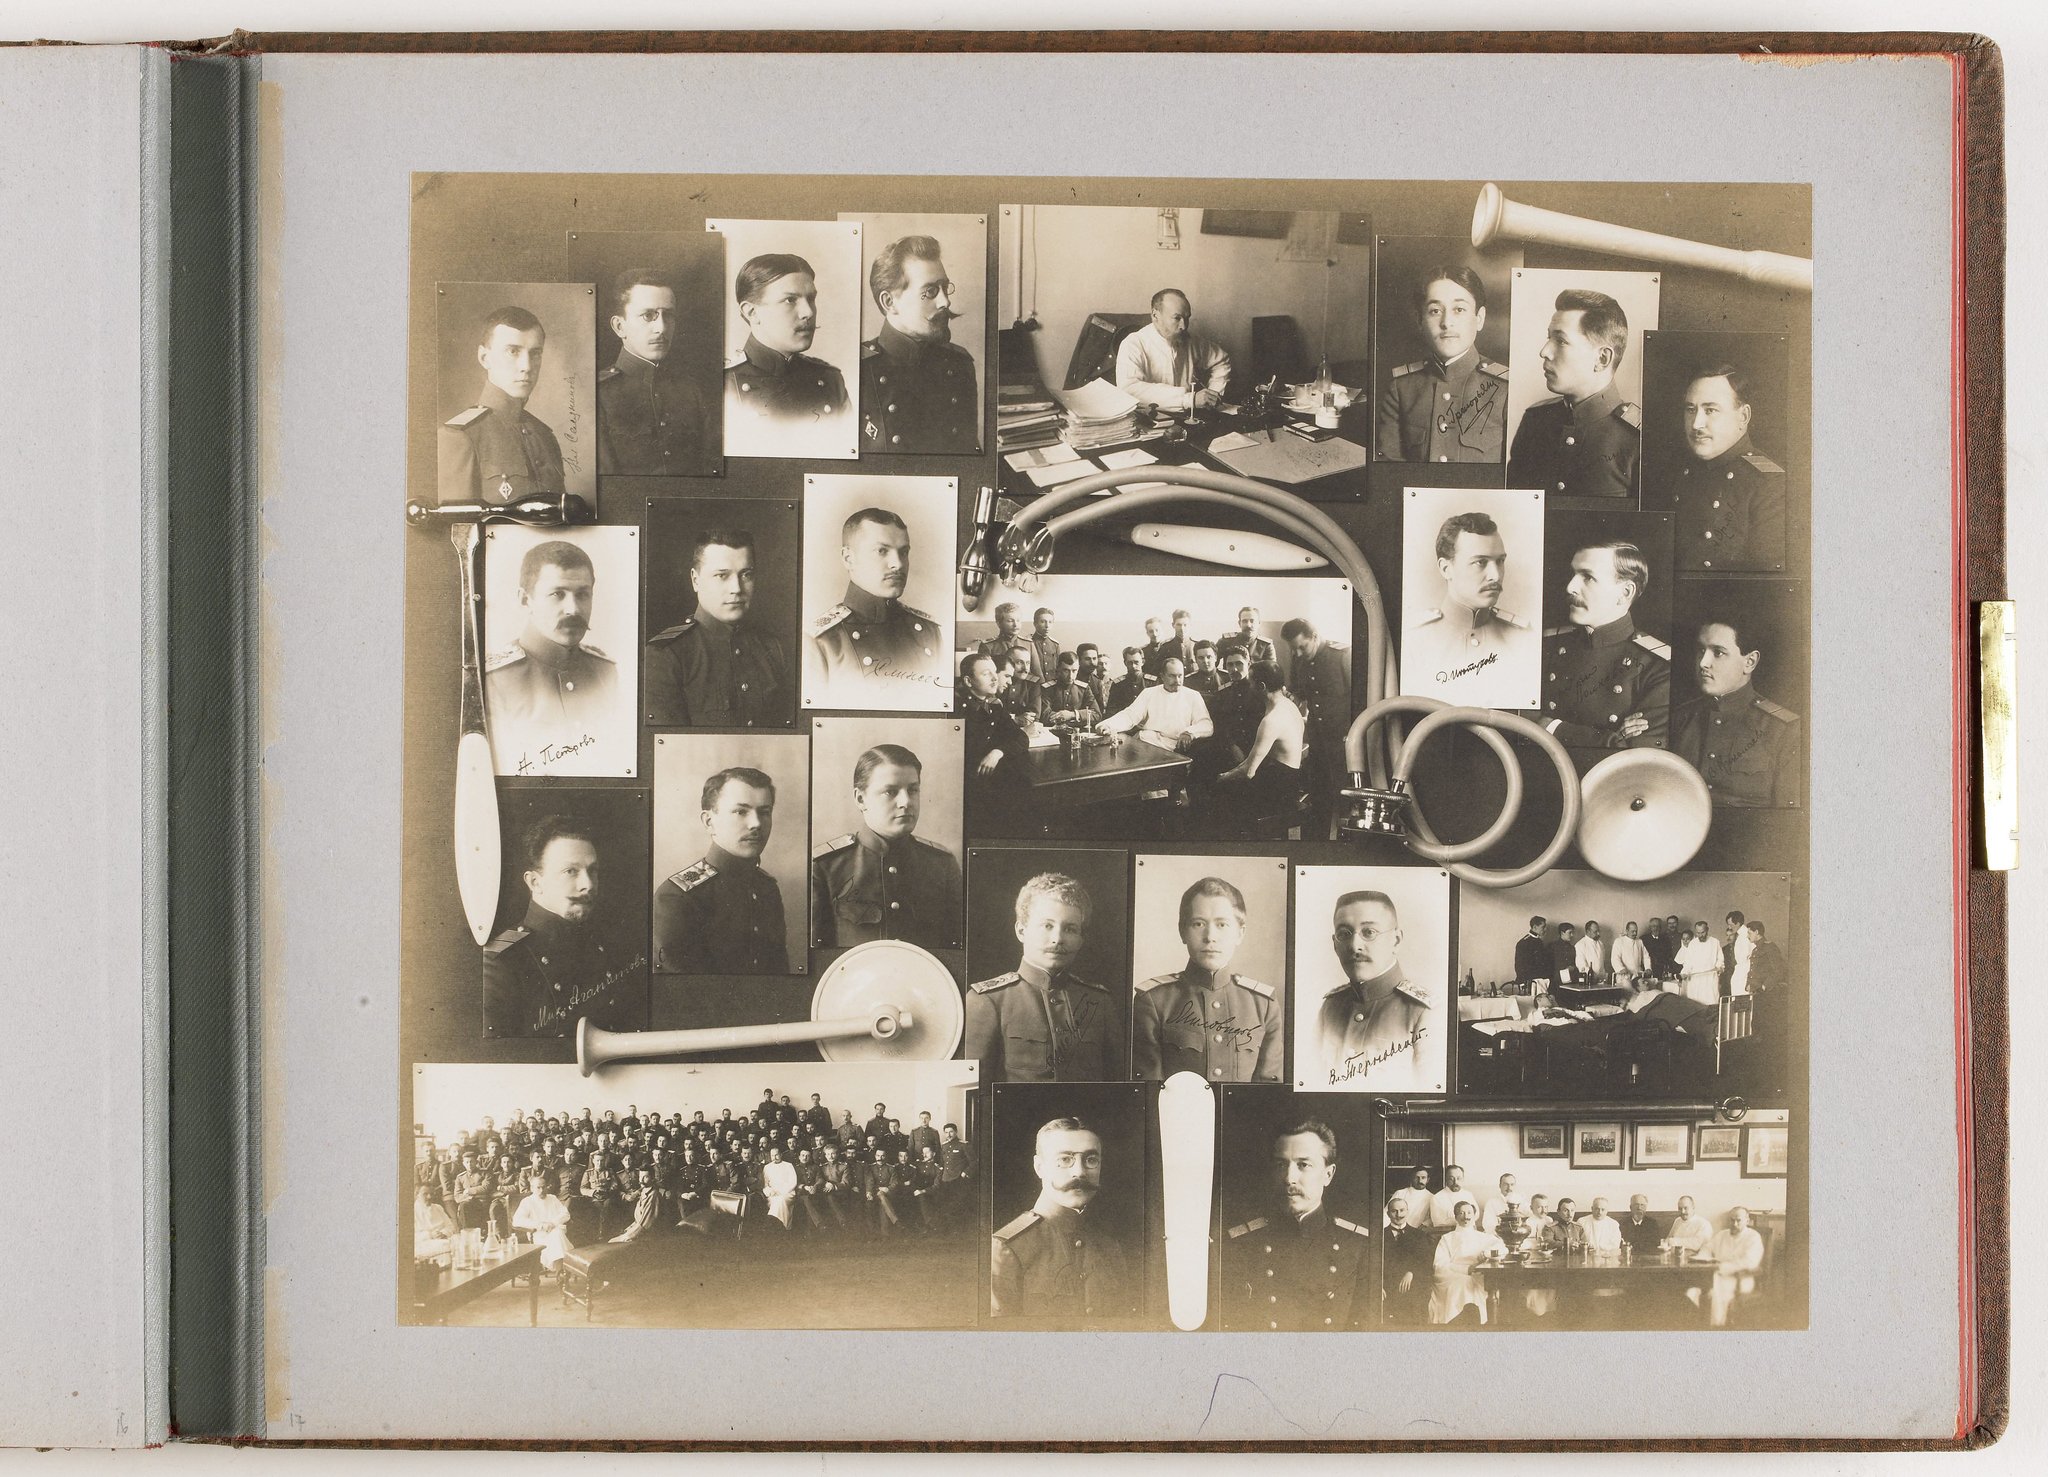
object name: photograph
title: Compositie van 26 foto's van personen aan de Keizerlijke Militair-Medische Academie, gecombineerd met decoratie van medische instrumenten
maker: v. sabelskij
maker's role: fotograaf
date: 1913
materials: cardboard, paper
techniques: salted paper print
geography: sint-petersburg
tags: medical instruments, physician, doctor, historical persons not known by name